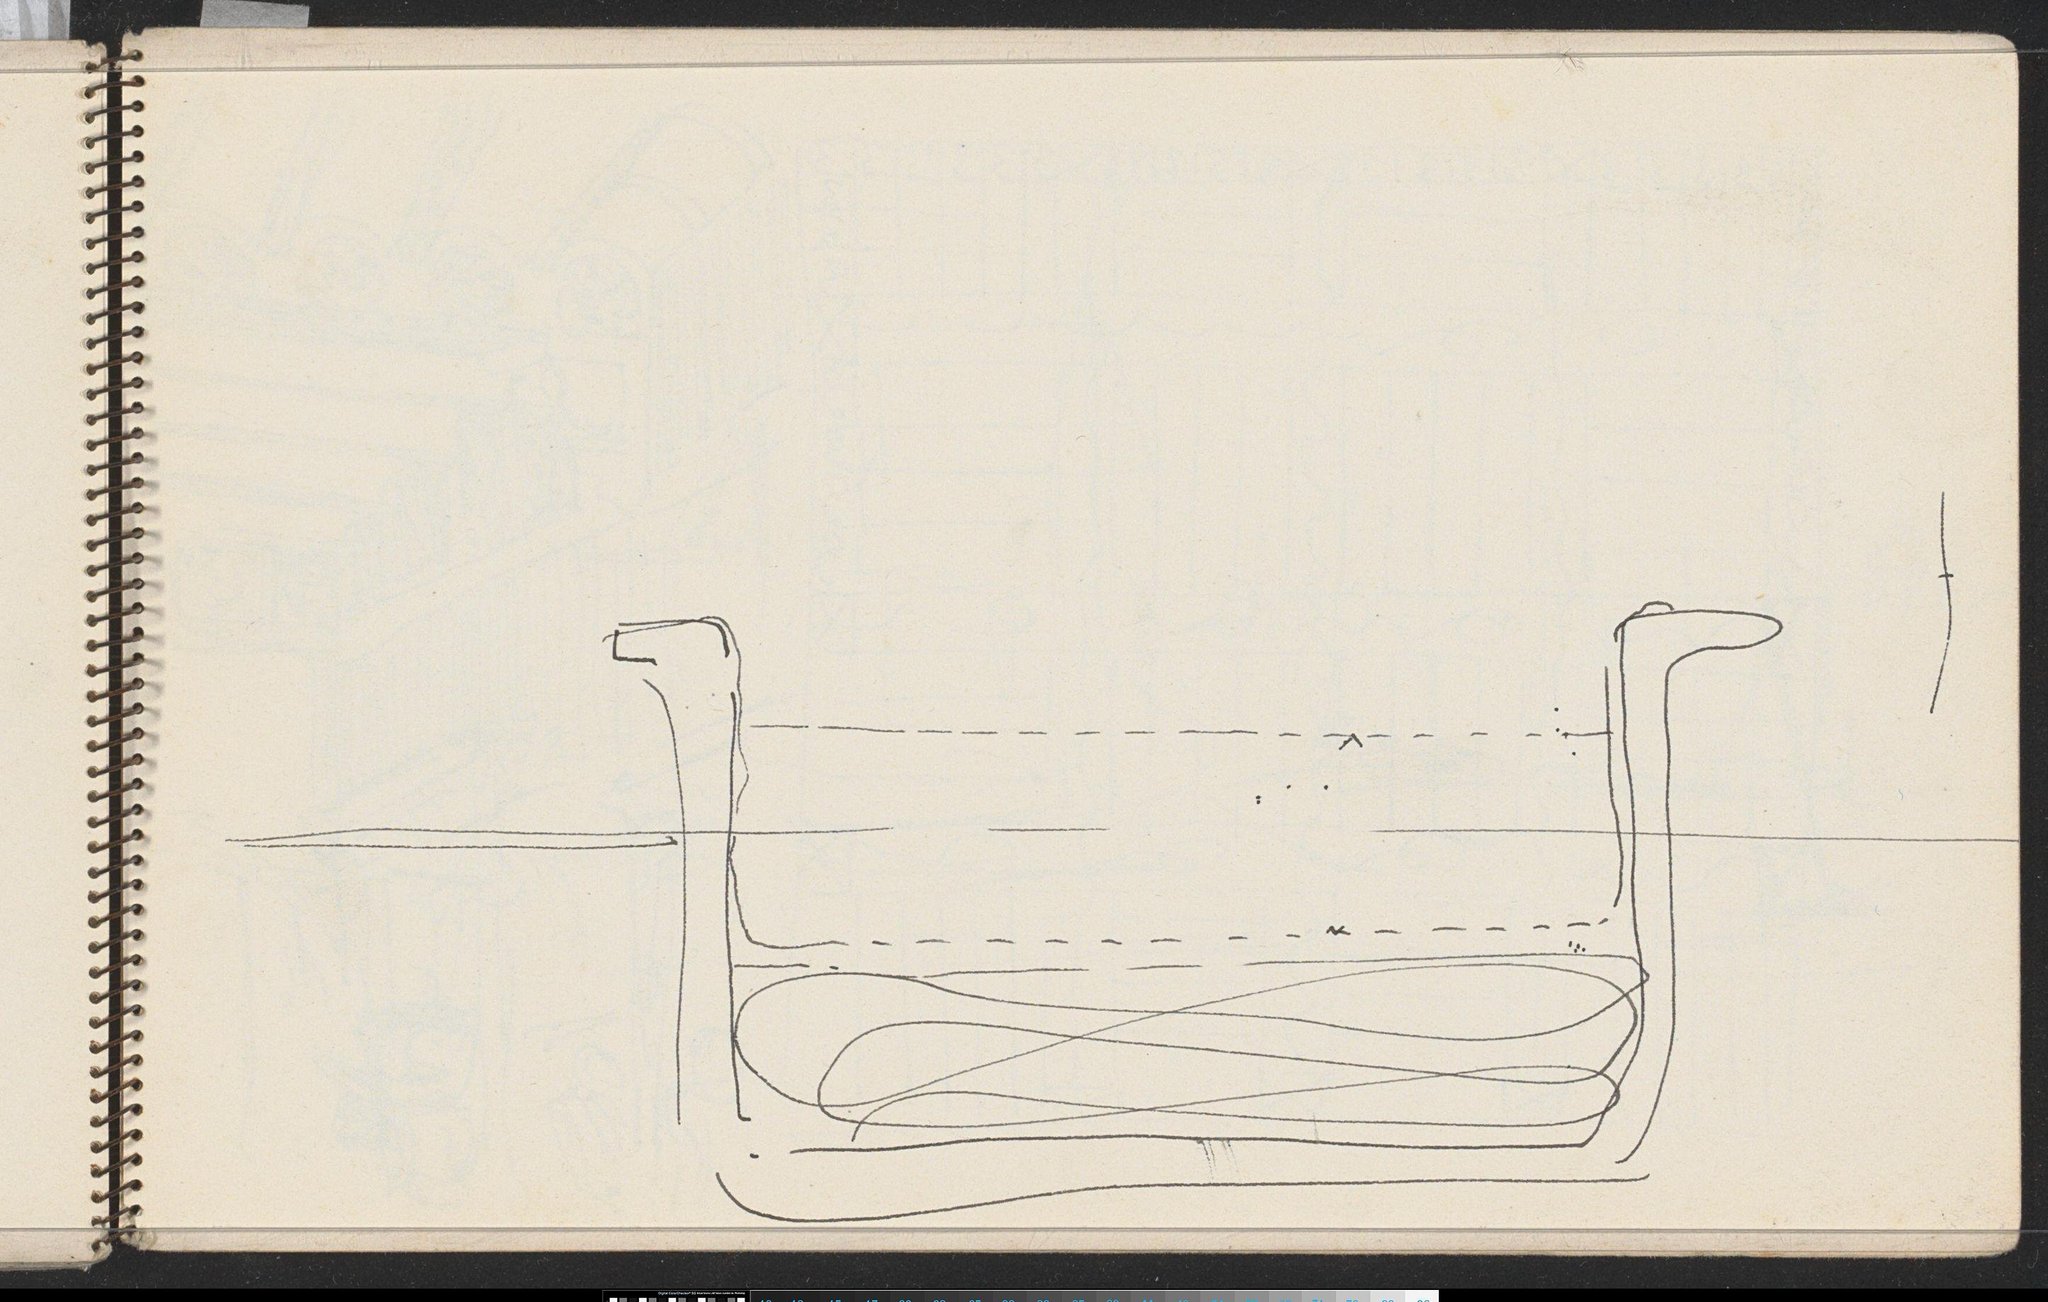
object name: sketchbook leaf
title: Ontwerp voor een tafel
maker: carel adolph lion cachet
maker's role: draughtsman, print maker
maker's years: 1864-1945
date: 1930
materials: ink, paper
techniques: pen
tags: table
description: Blad 17 recto uit een schetsboek met 20 bladen.